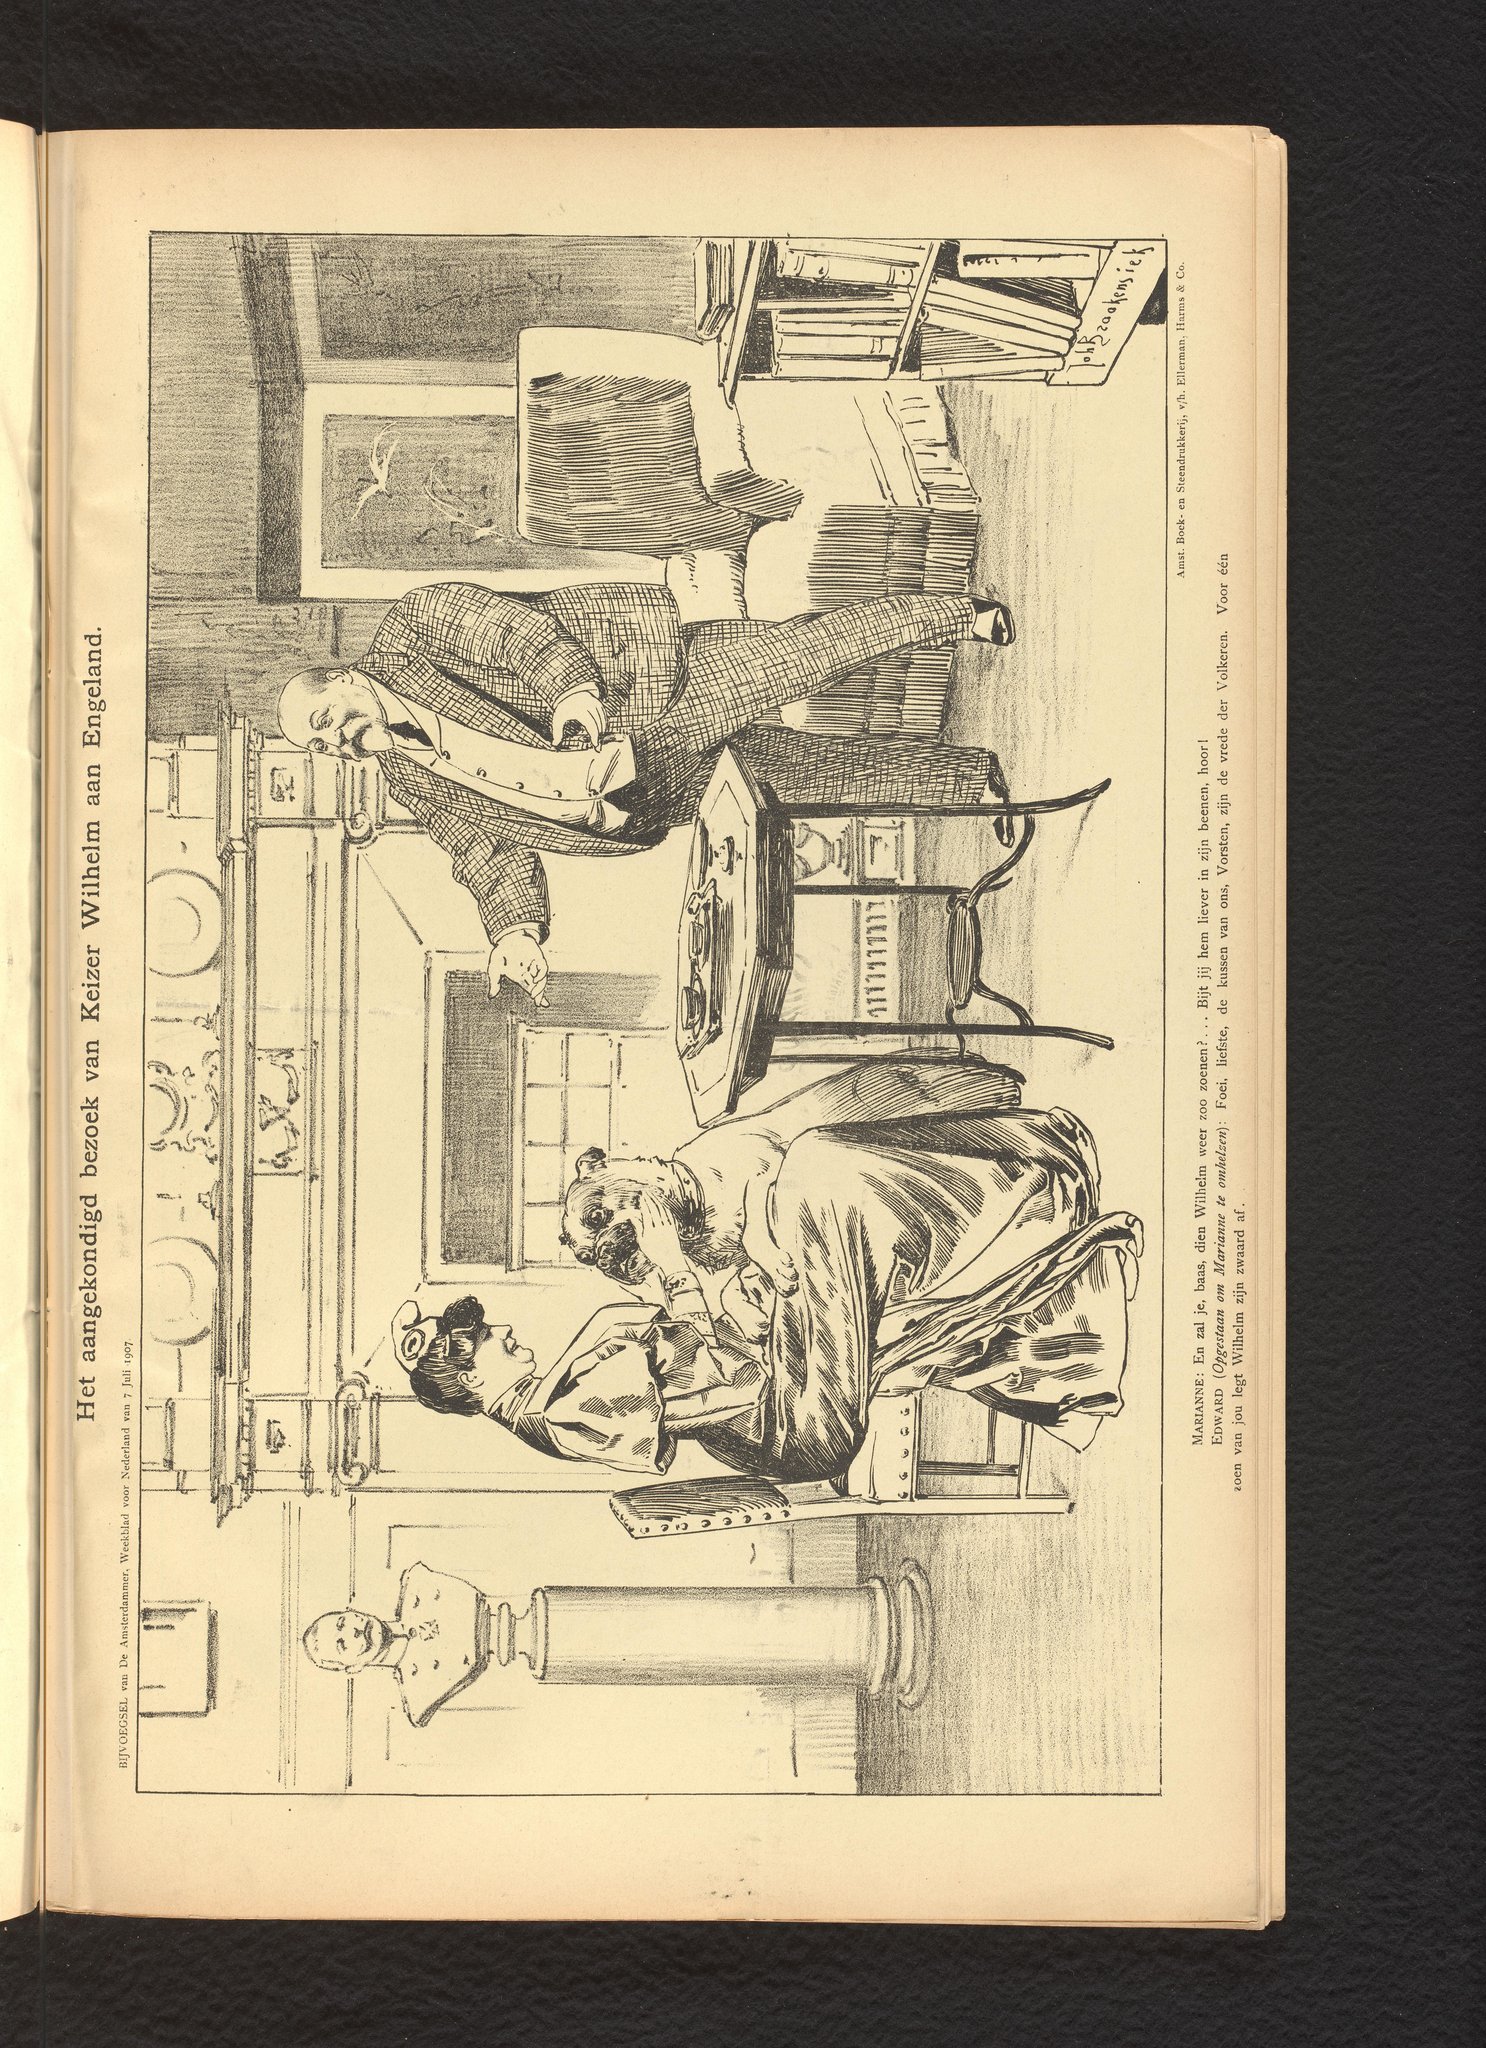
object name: cartoon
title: Het aangekondigd bezoek van Keizer Wilhelm aan Engeland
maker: johan braakensiek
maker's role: draughtsman, print maker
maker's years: 1858-1940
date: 1907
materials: paper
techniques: lithograph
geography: netherlands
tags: wilhelm ii (keizer van duitsland), drawing-room, 'salon', personifications of countries, nations, states, districts, etc., piece of sculpture, reproduction of a piece of sculpture, political caricatures and satires, dog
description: De Engelse koning Edward VII en Marianne (Frankrijk) als echtpaar in de salon. Marianne aait de Engelse bulldog en moedigt hem aan de keizer te bijten. Naast de haard een buste van de Duitse keizer Wilhelm II.